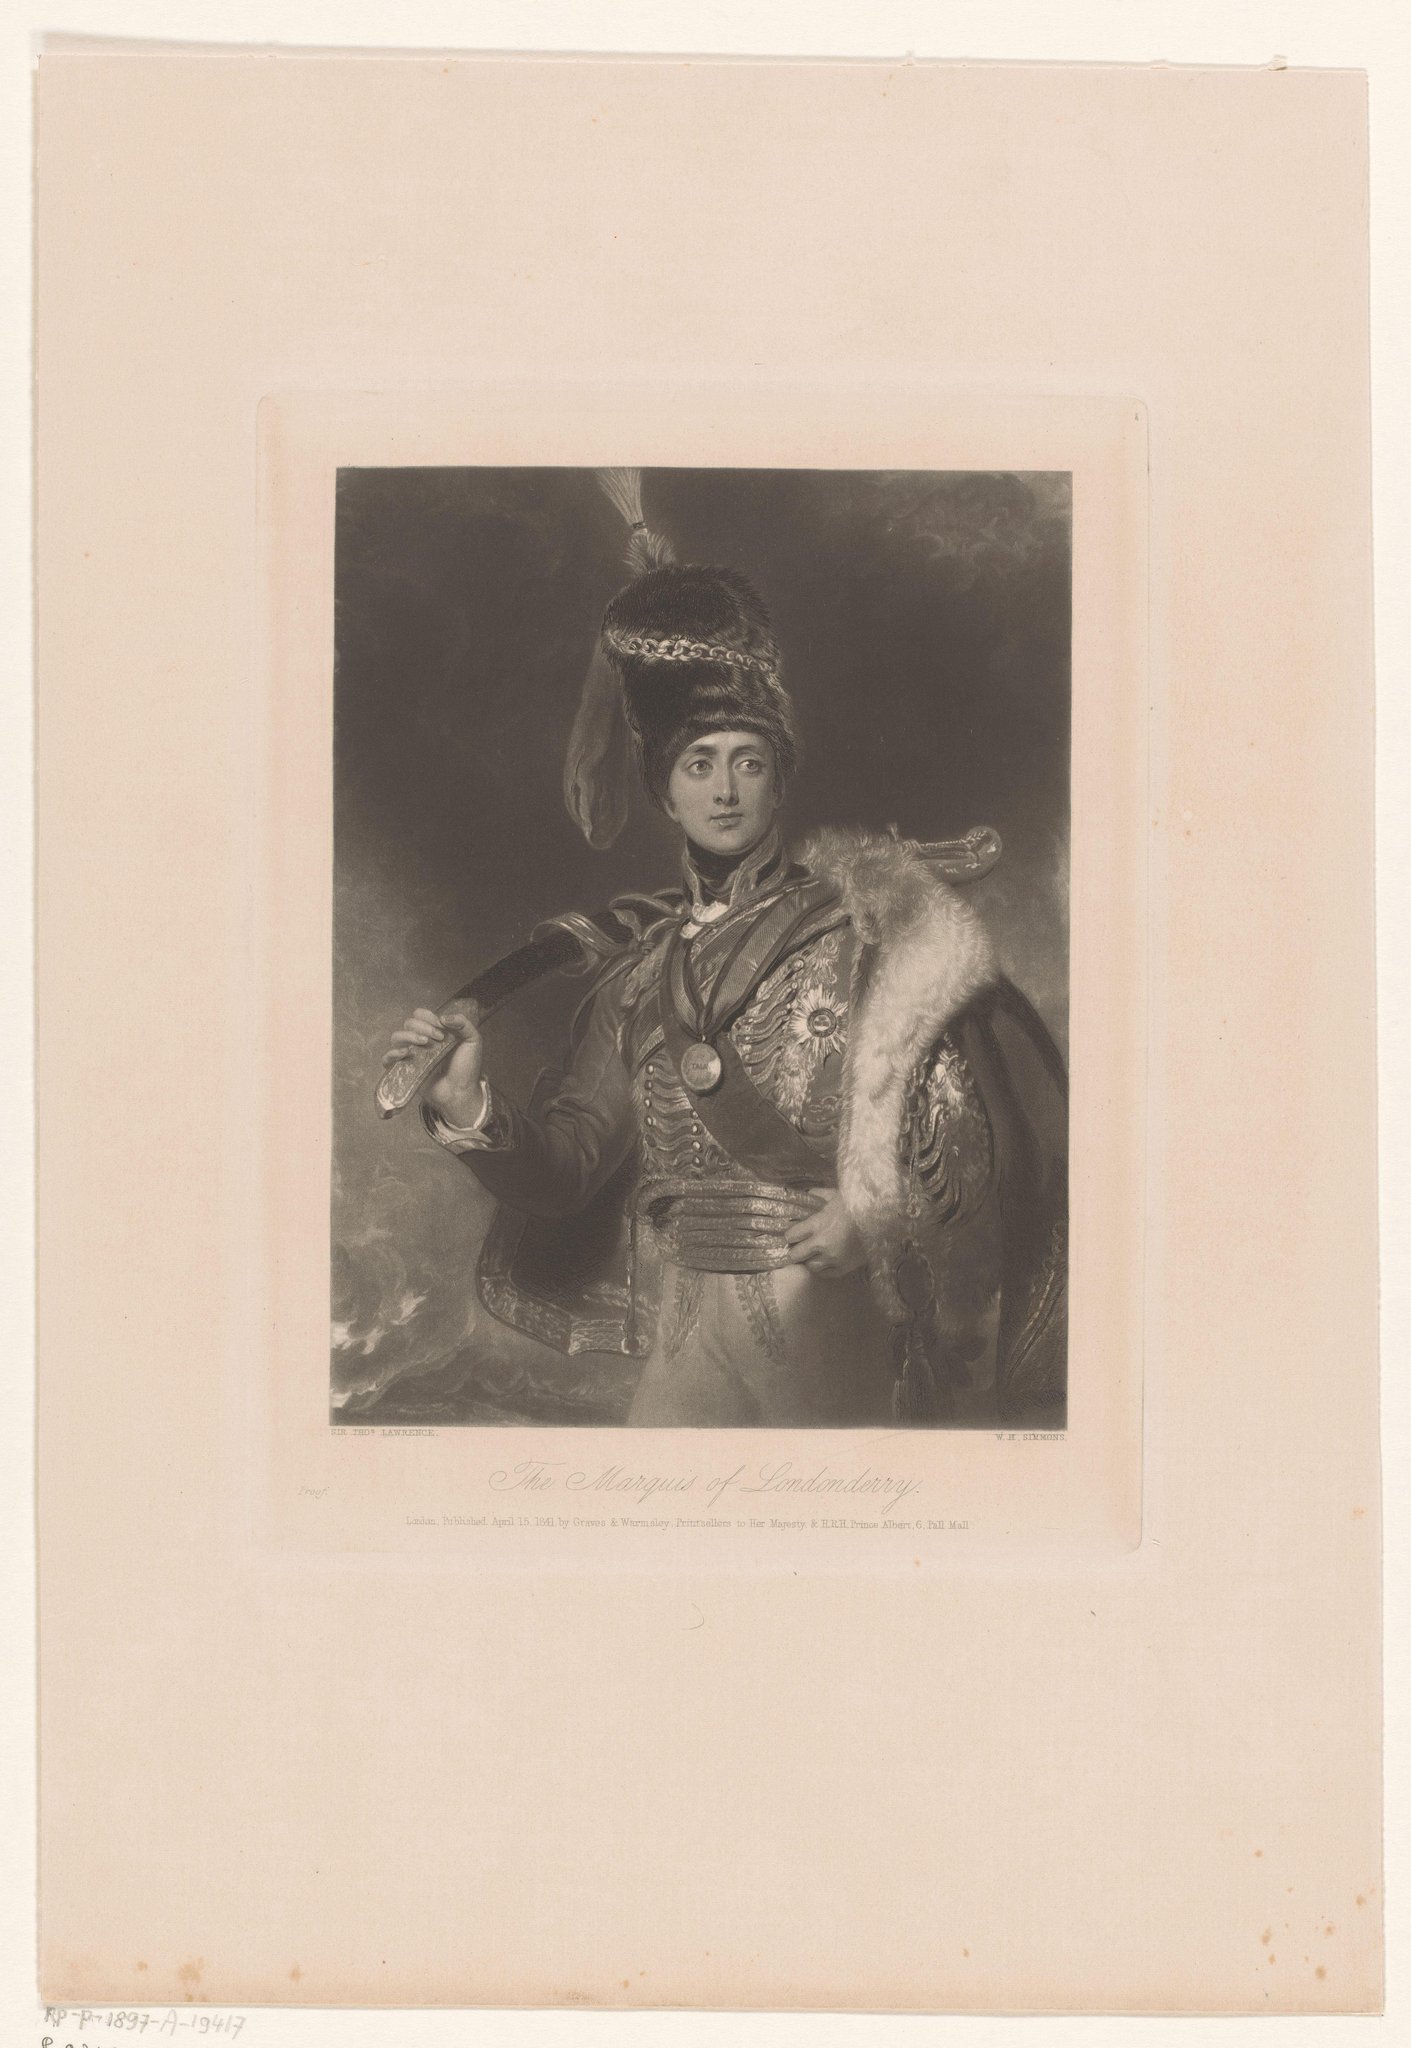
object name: print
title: Portret van Charles William Vane gekleed als Charles William Stewart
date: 1841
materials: paper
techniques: etching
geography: london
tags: london, charles vane (3rd marquess of londonderry), historical persons, politician, e.g. party leader, officer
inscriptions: collector's mark: Lugt 2228